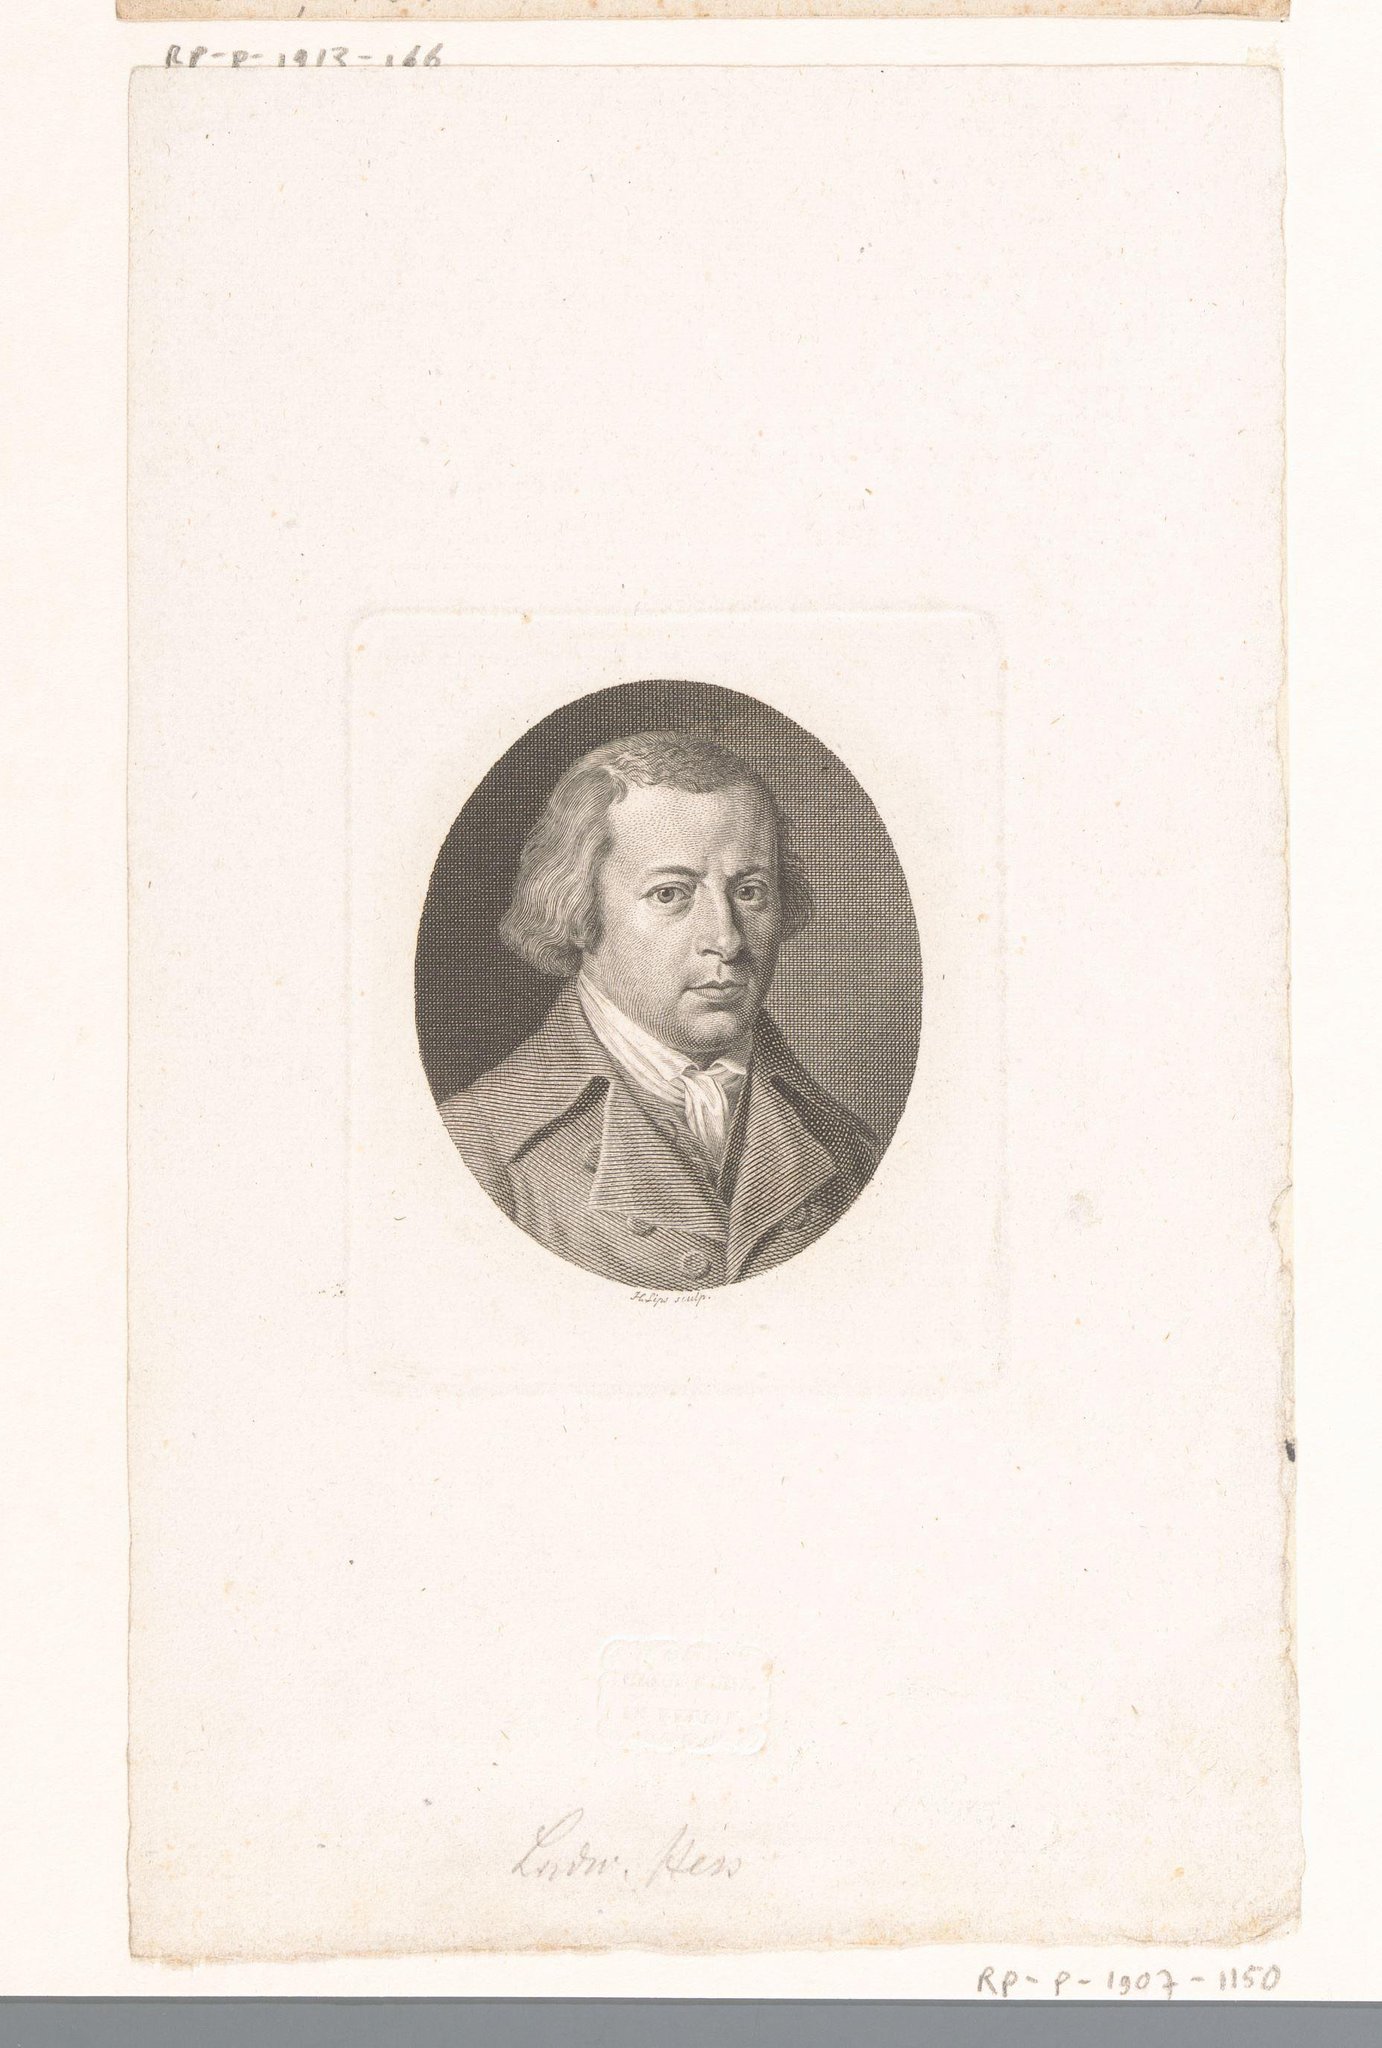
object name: print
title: Portret van Ludwig Hess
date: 1768-1817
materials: paper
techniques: engraving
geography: berlin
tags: painter, print maker, ludwig hess, historical persons, portrait, self-portrait of graphic artist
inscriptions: collector's mark: Lugt 2228